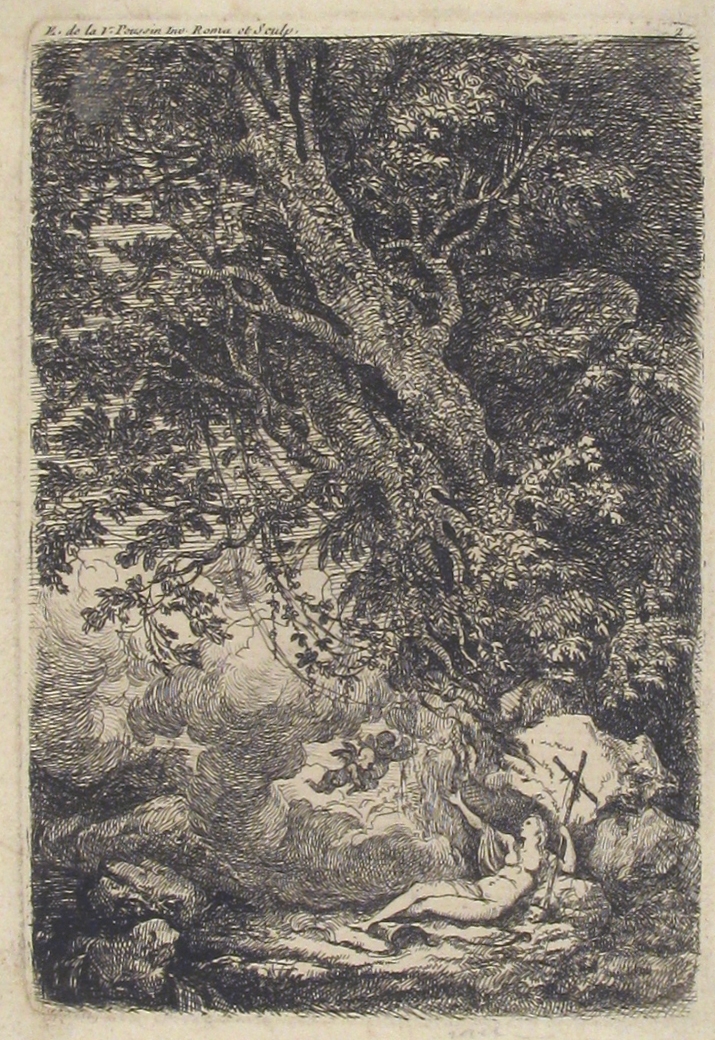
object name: print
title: Female Saint in a Landscape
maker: etienne de lavallée-poussin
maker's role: artist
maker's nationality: french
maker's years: 1733-1793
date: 1701-1800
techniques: etching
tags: female nudes,cross,saints